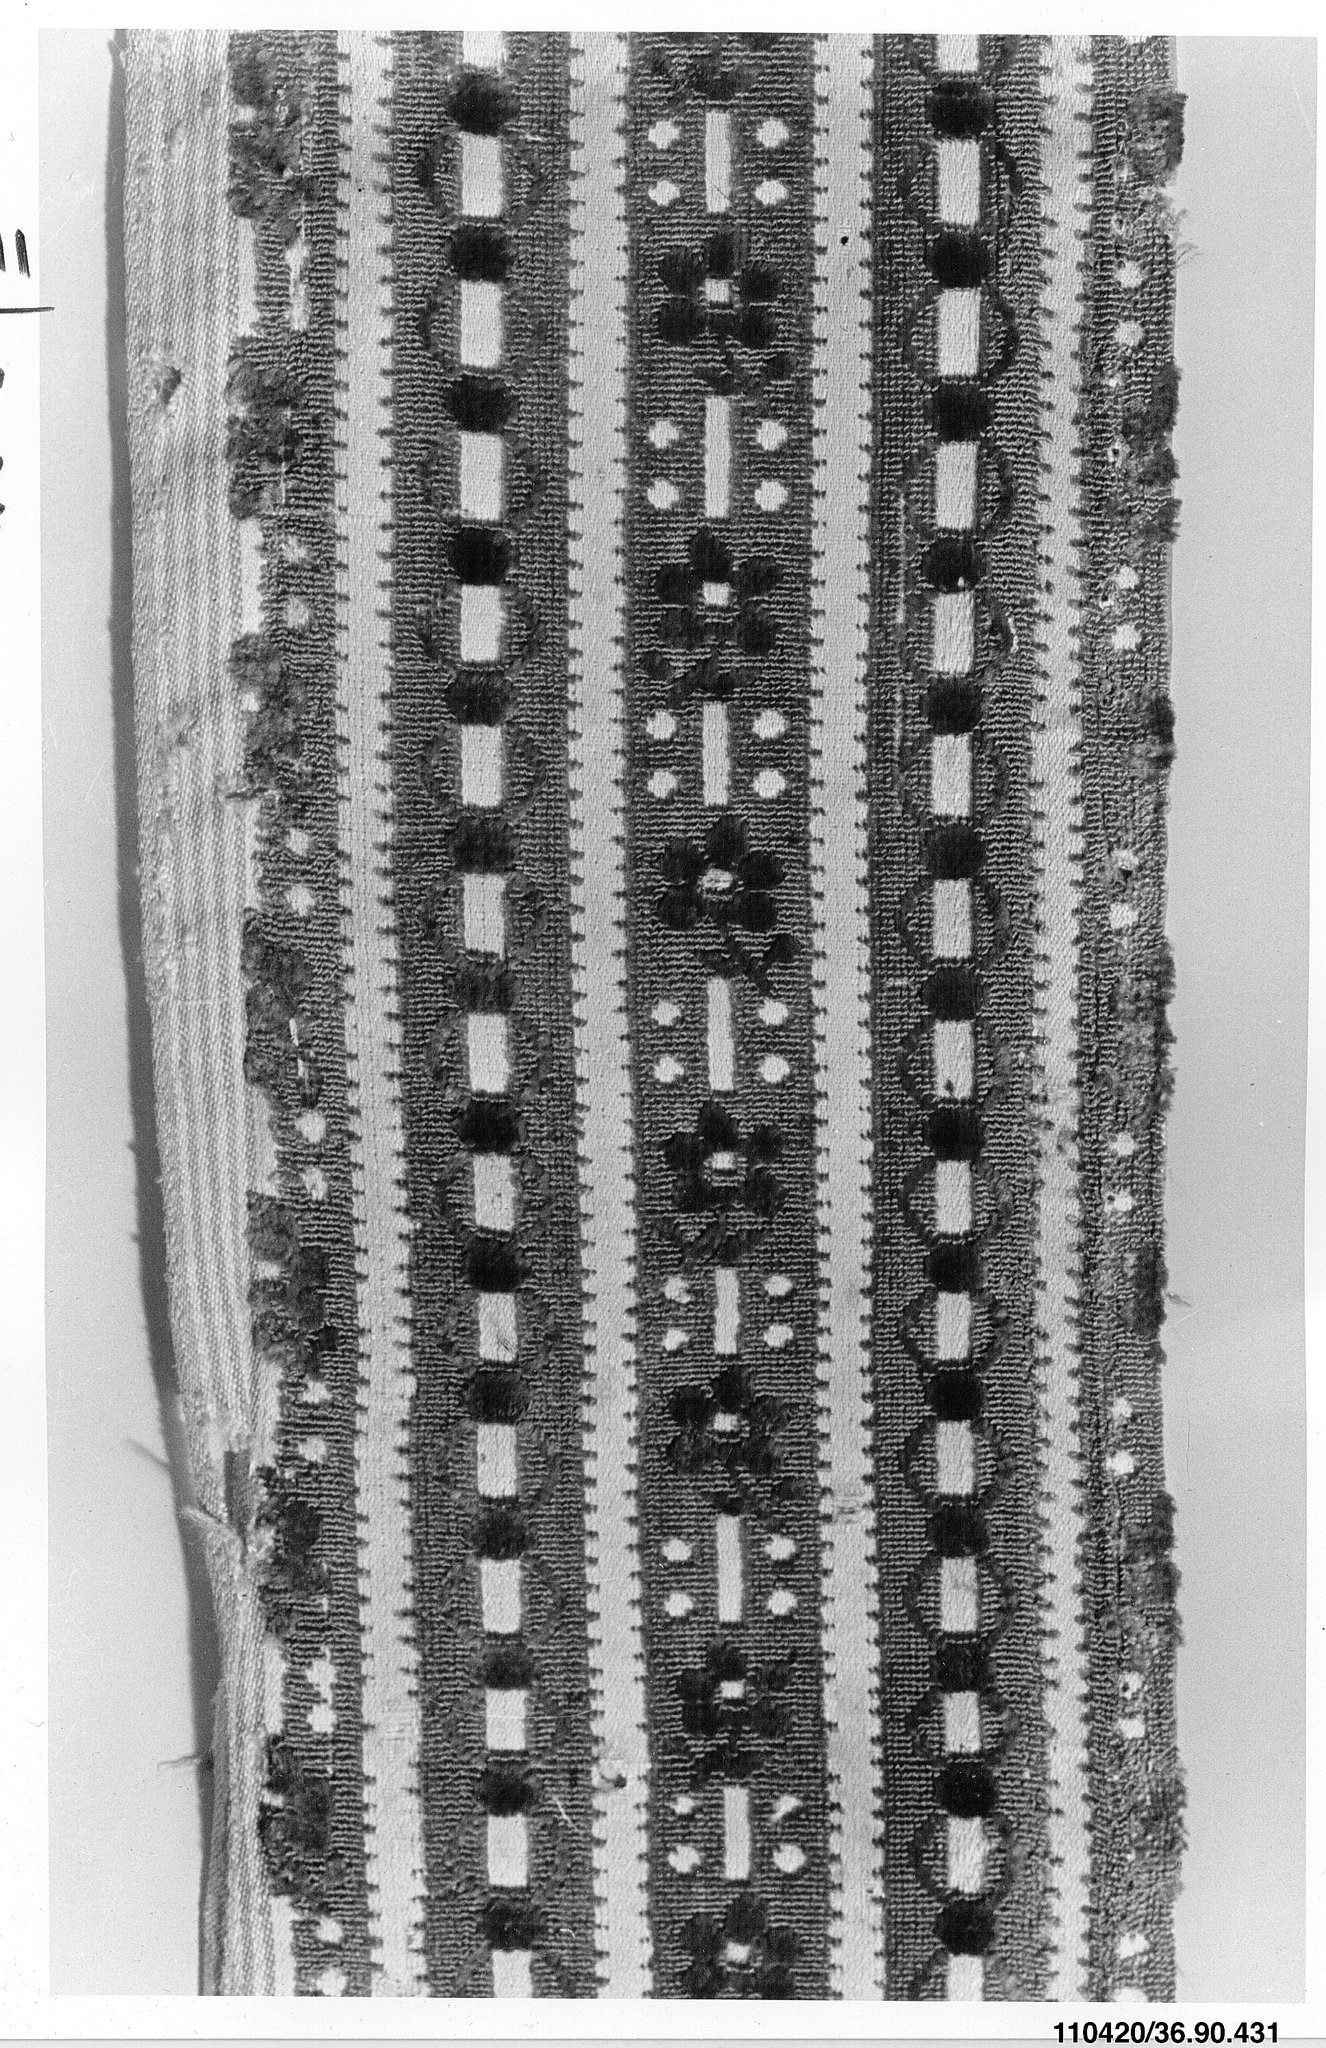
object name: piece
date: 1501-1700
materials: silk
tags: flowers